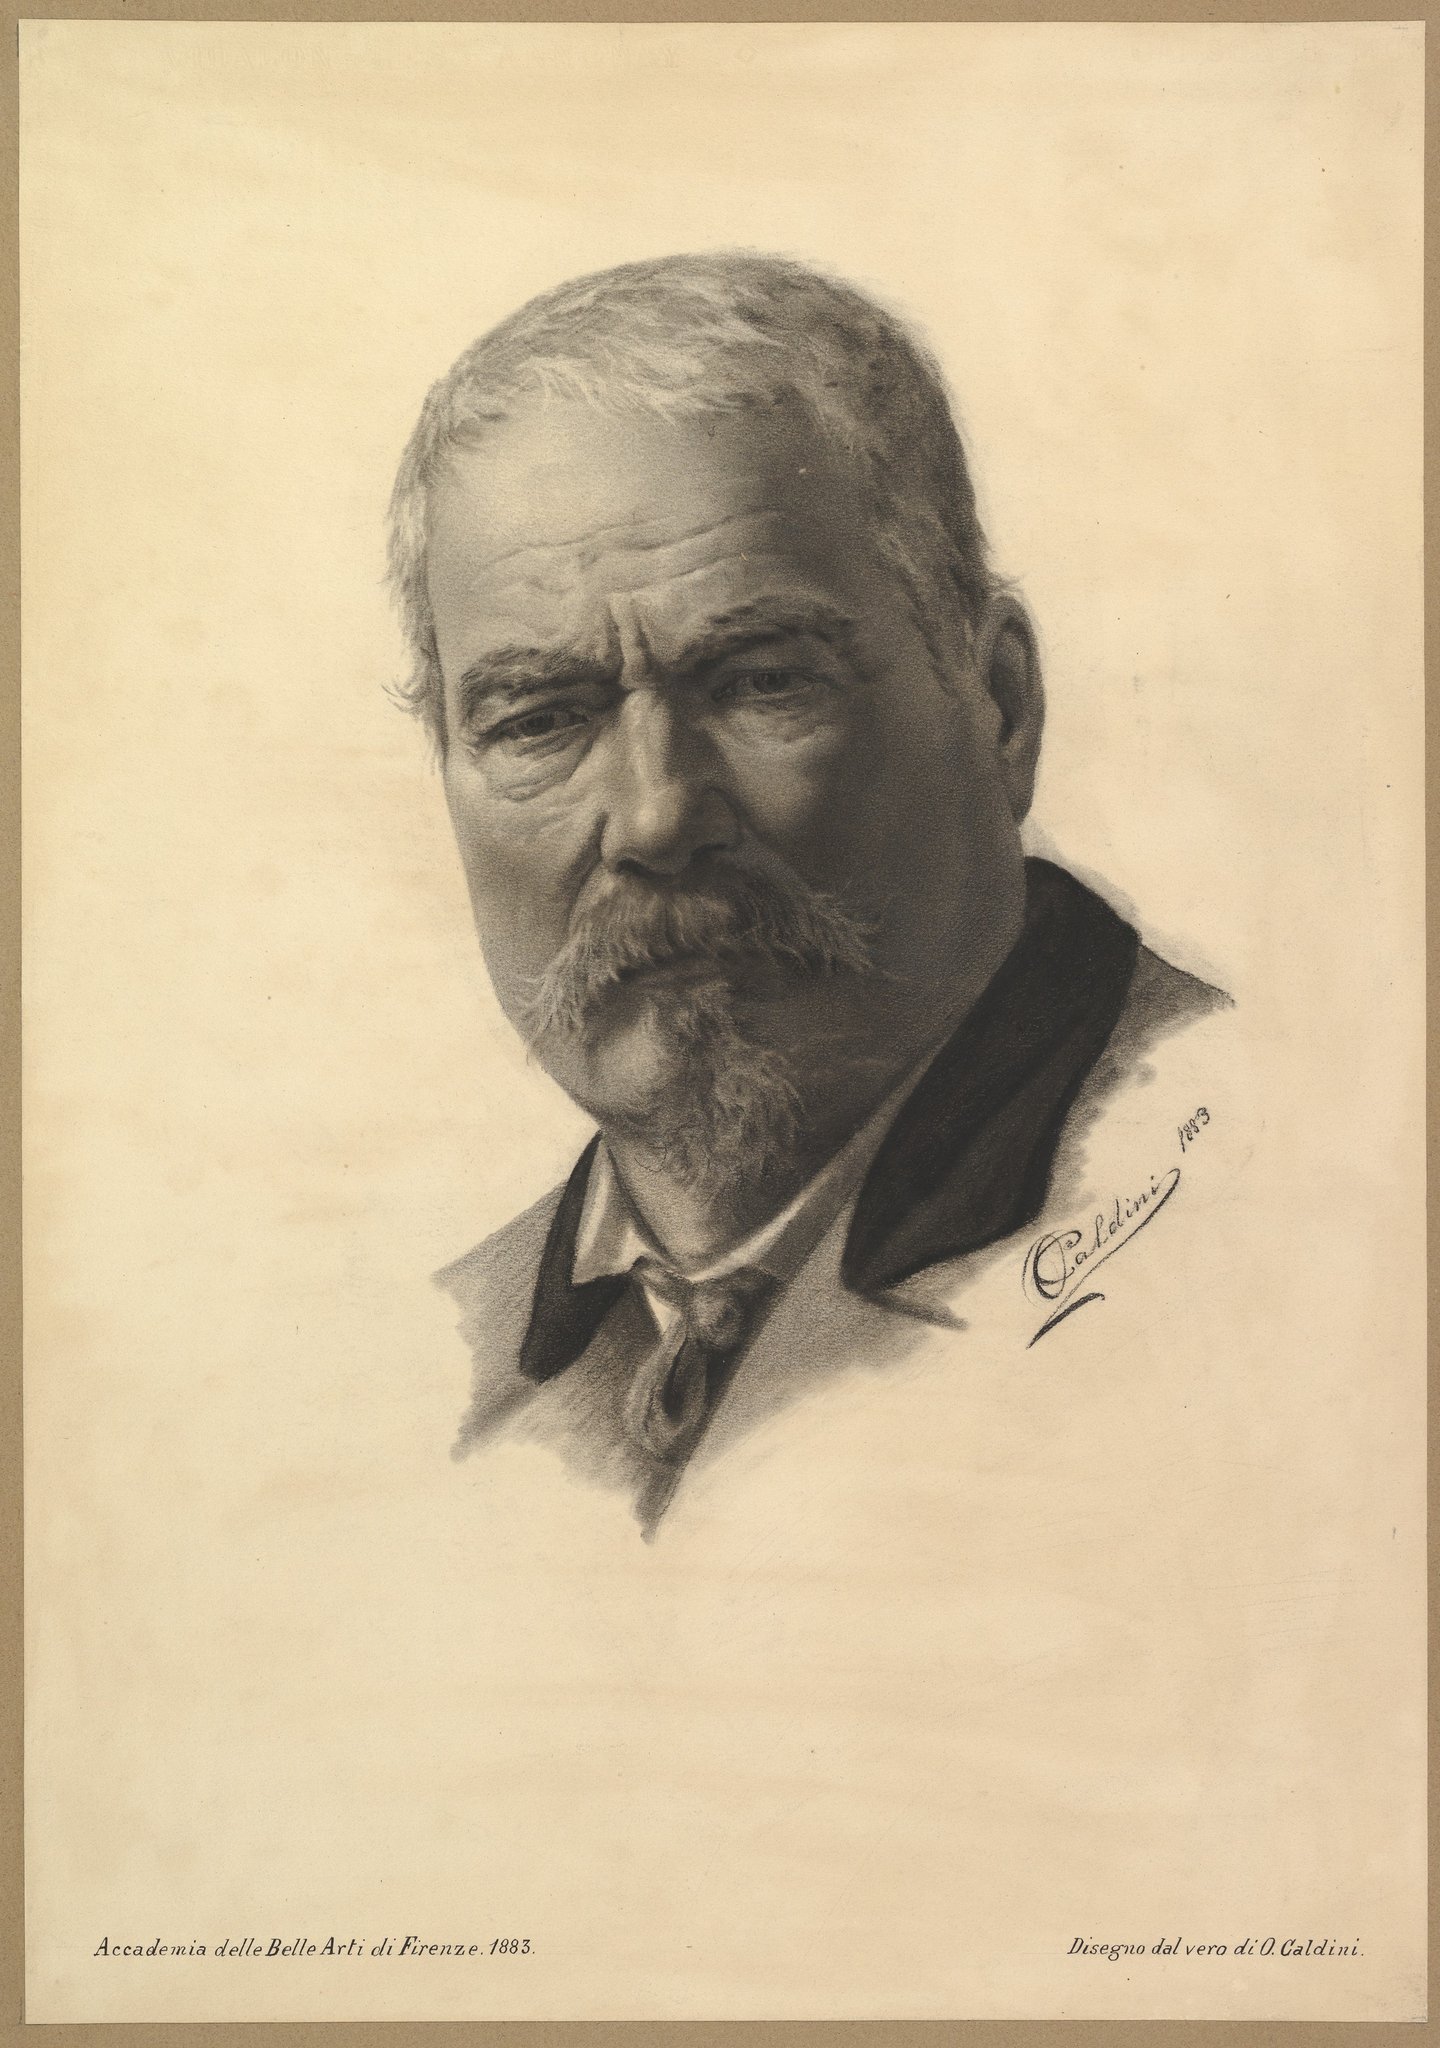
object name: drawing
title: Portrait Head of a Man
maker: oresto caldini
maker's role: artist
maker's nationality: italian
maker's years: 19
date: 1800-1900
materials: charcoal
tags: men,portraits